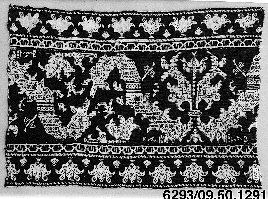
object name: textile fragment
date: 1701-1800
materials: linen, silk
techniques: embroidery, weave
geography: morocco